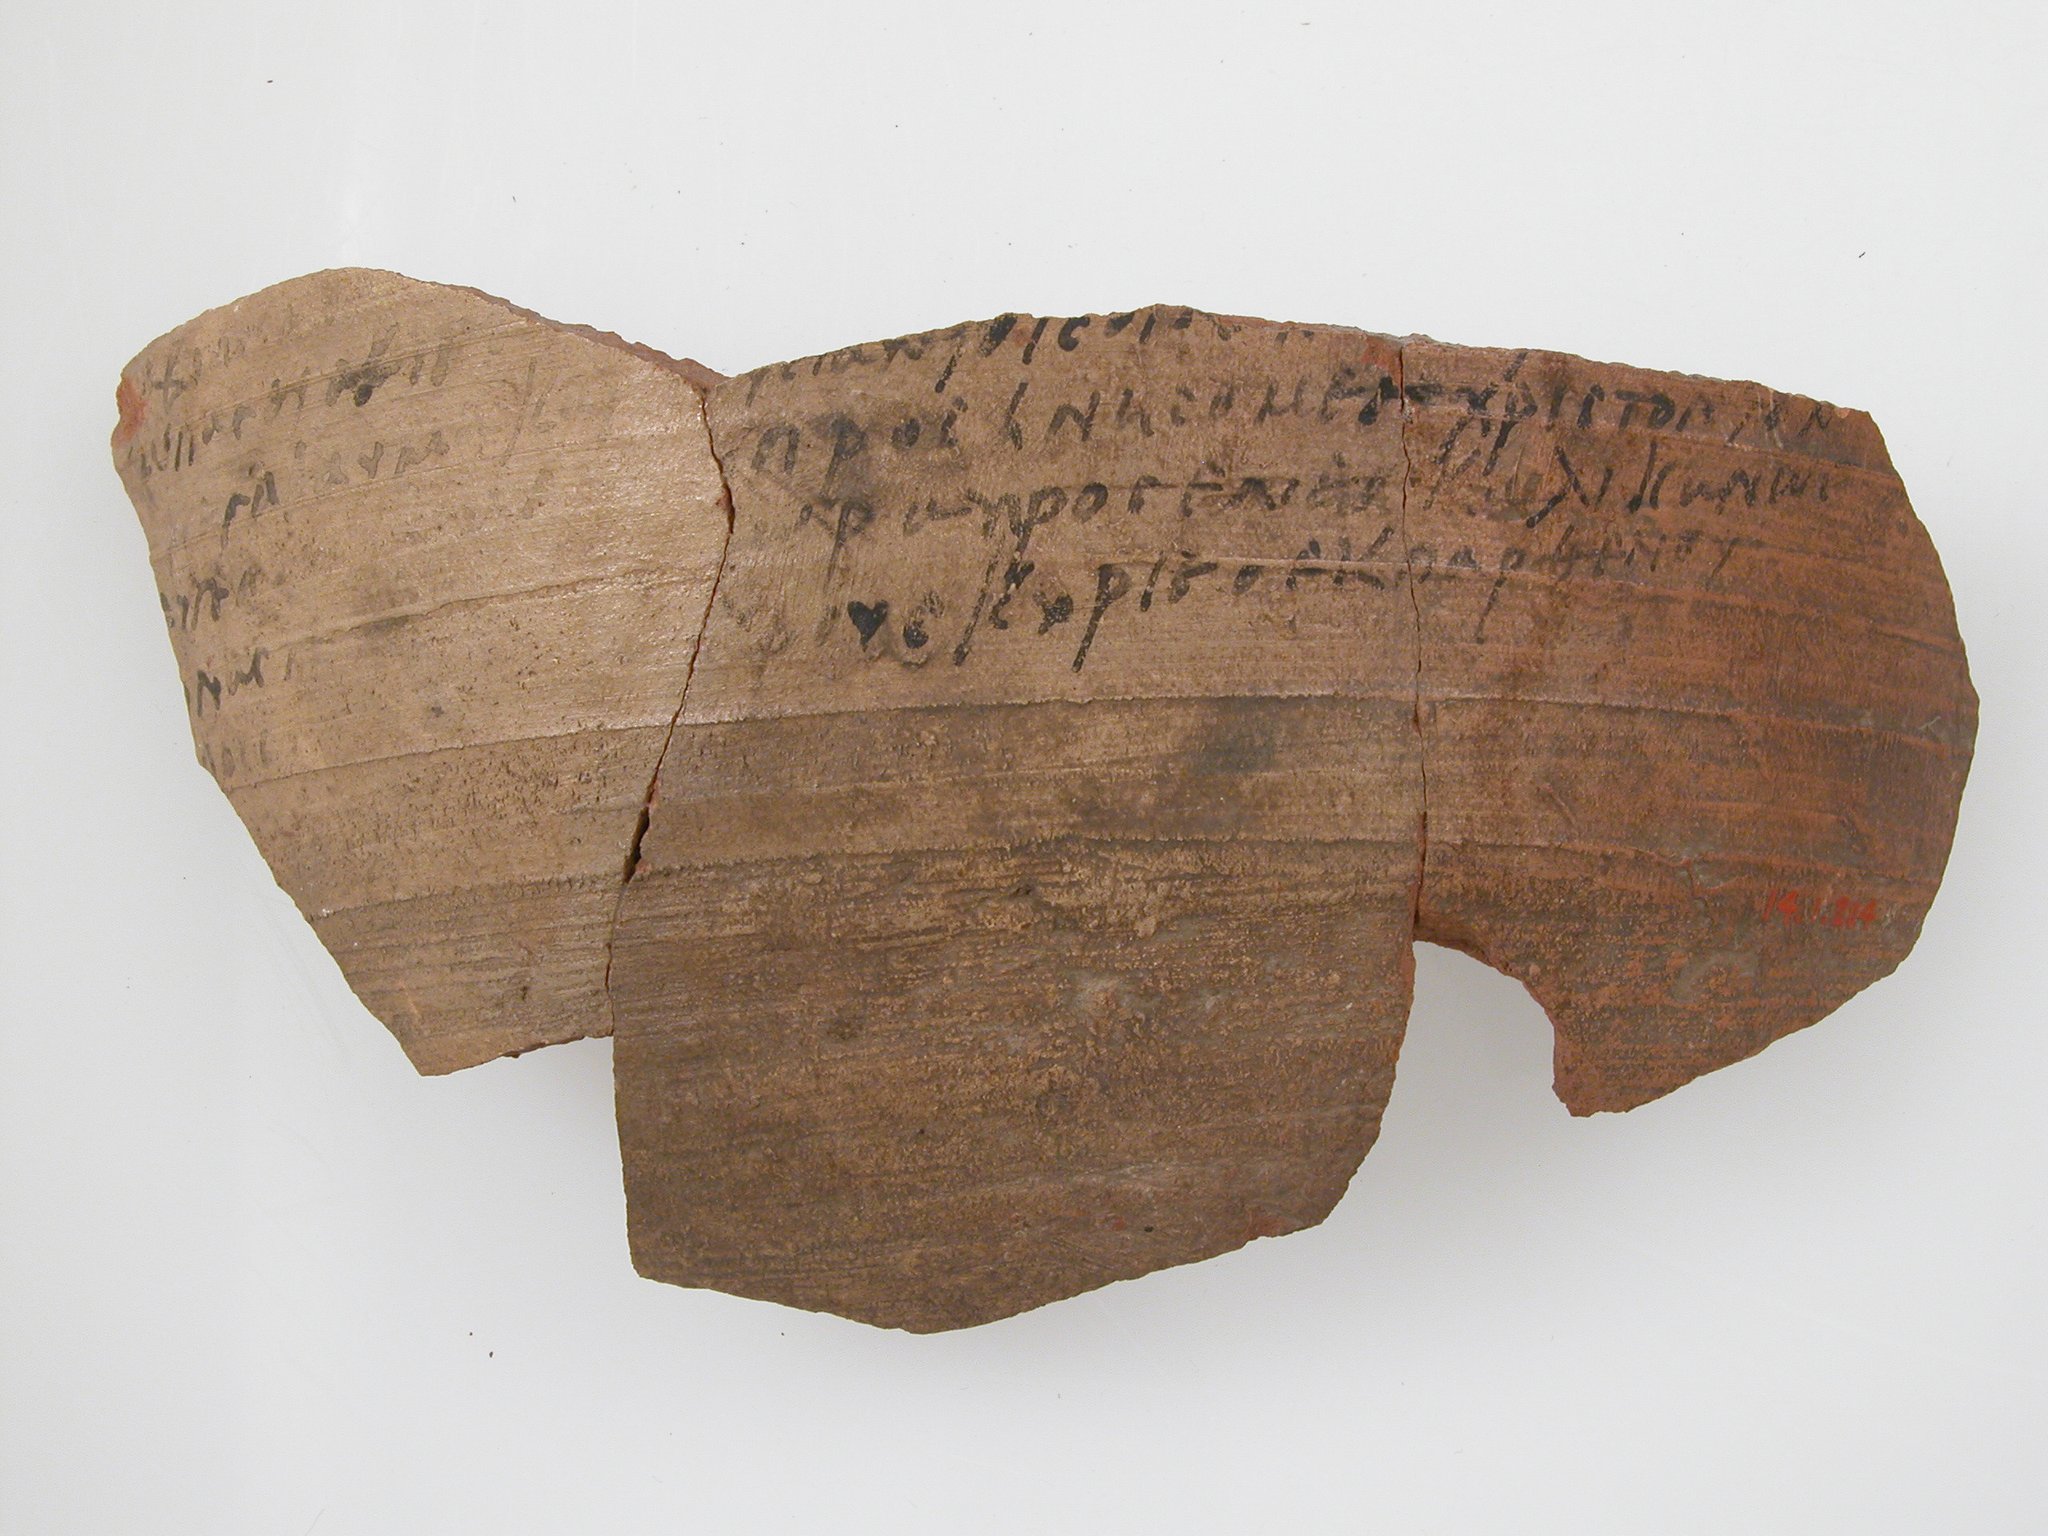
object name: ostrakon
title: Ostrakon with Troparion (?)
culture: coptic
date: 580-640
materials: ink, pottery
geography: egypt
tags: greek